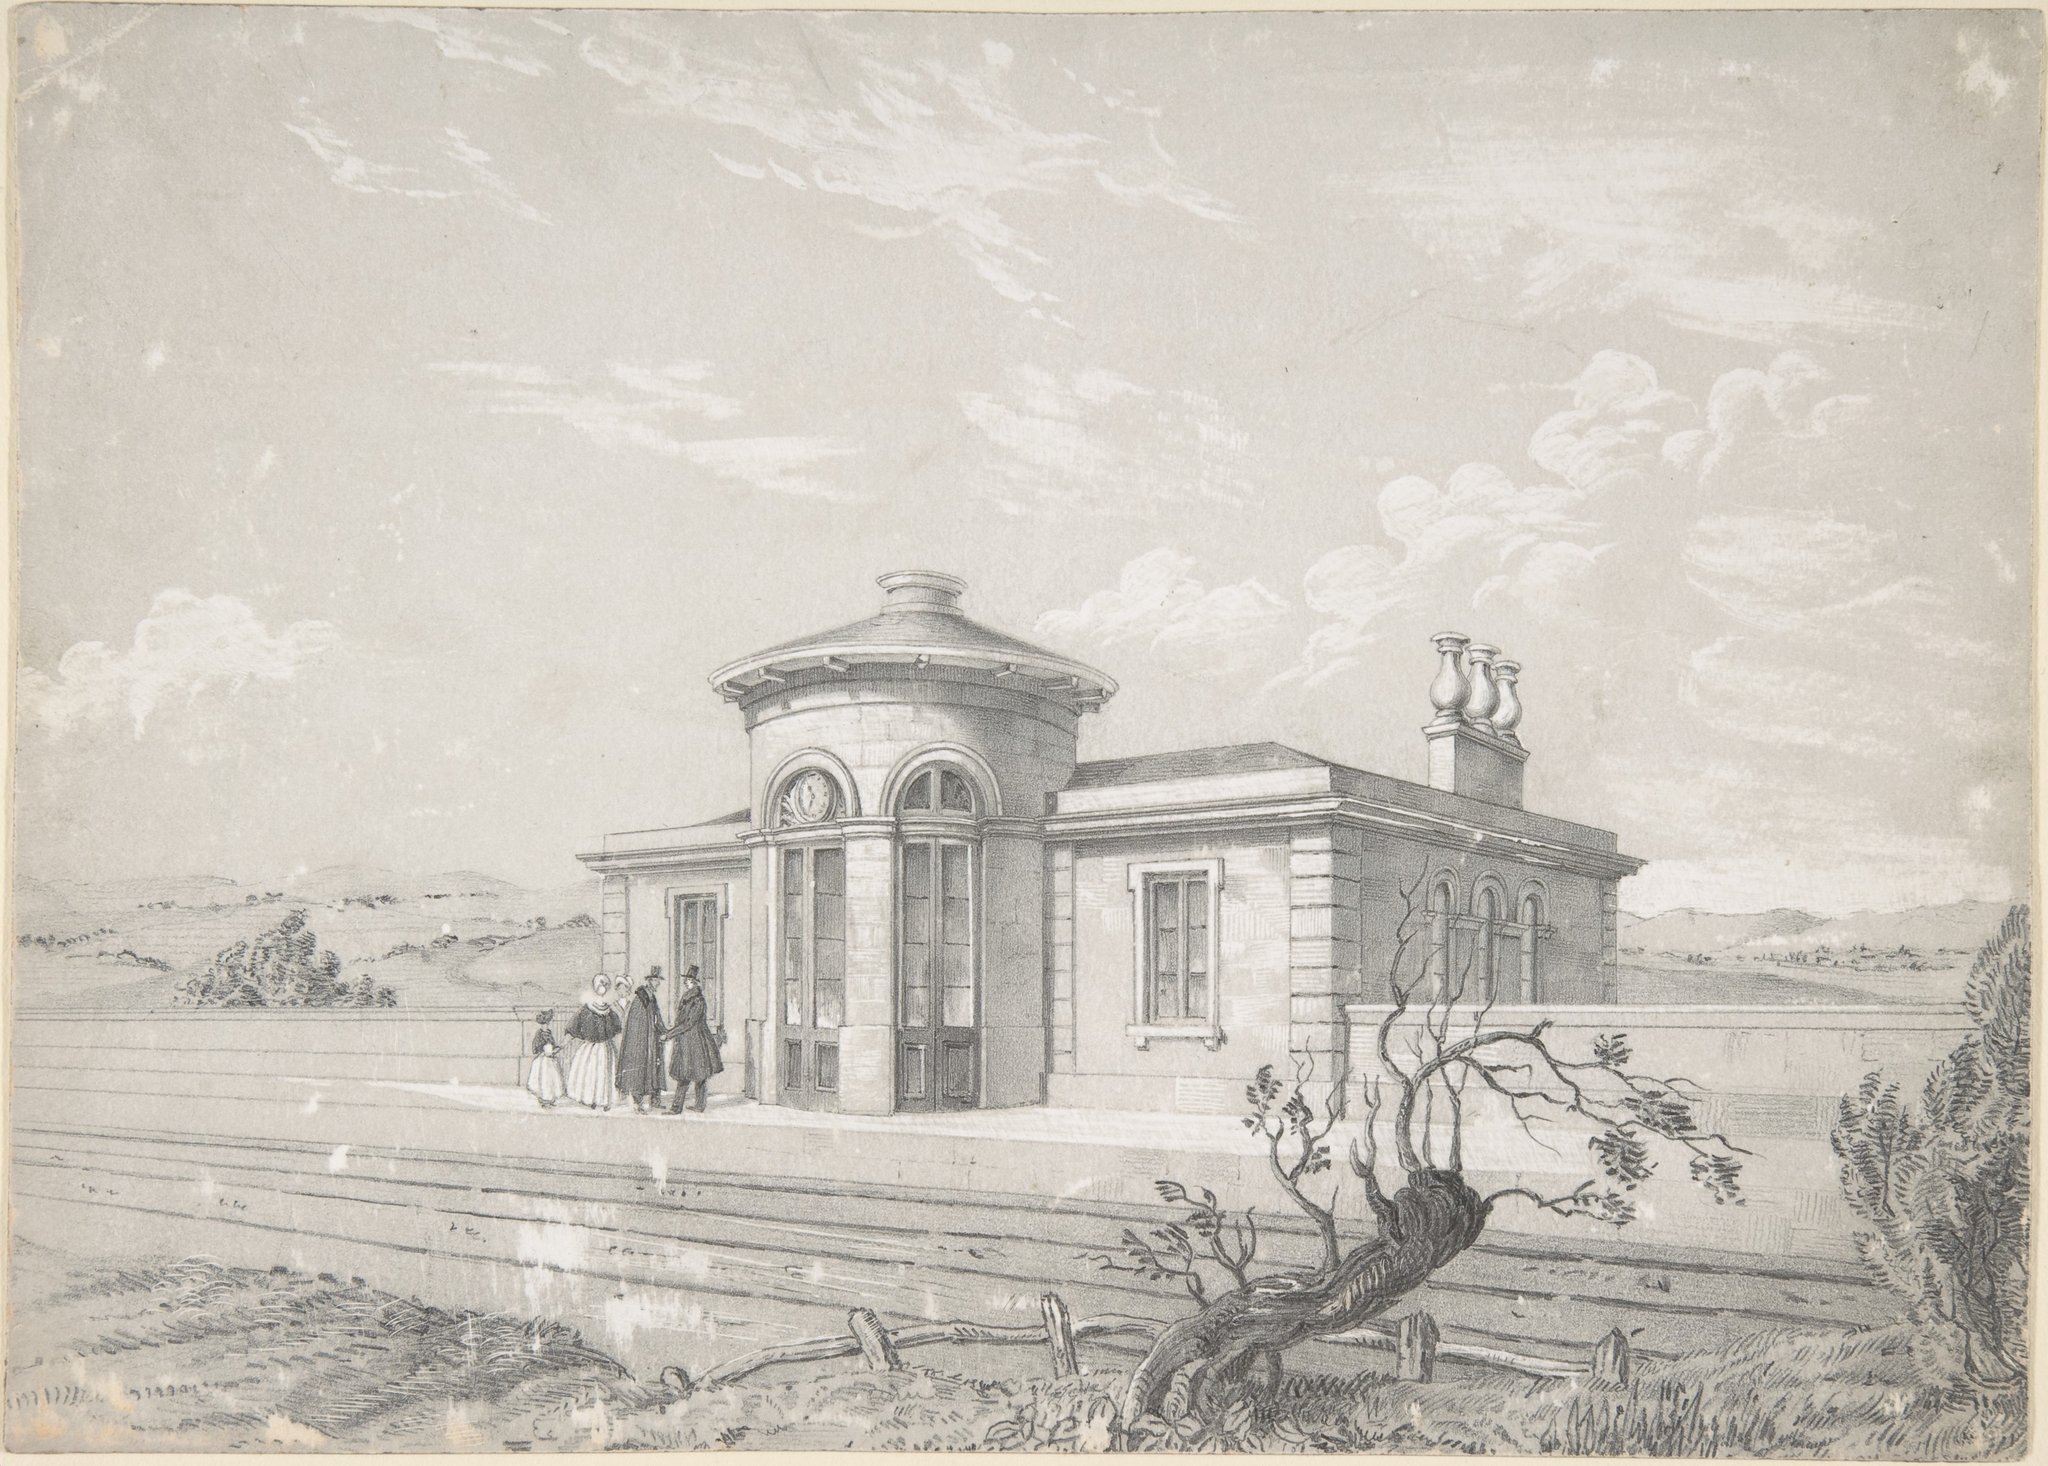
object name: drawing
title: Design for a Railroad Station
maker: anonymous, french, 19th century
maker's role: artist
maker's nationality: french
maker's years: 1800-1900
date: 1801-1900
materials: graphite, paper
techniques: heightening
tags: train stations,railways